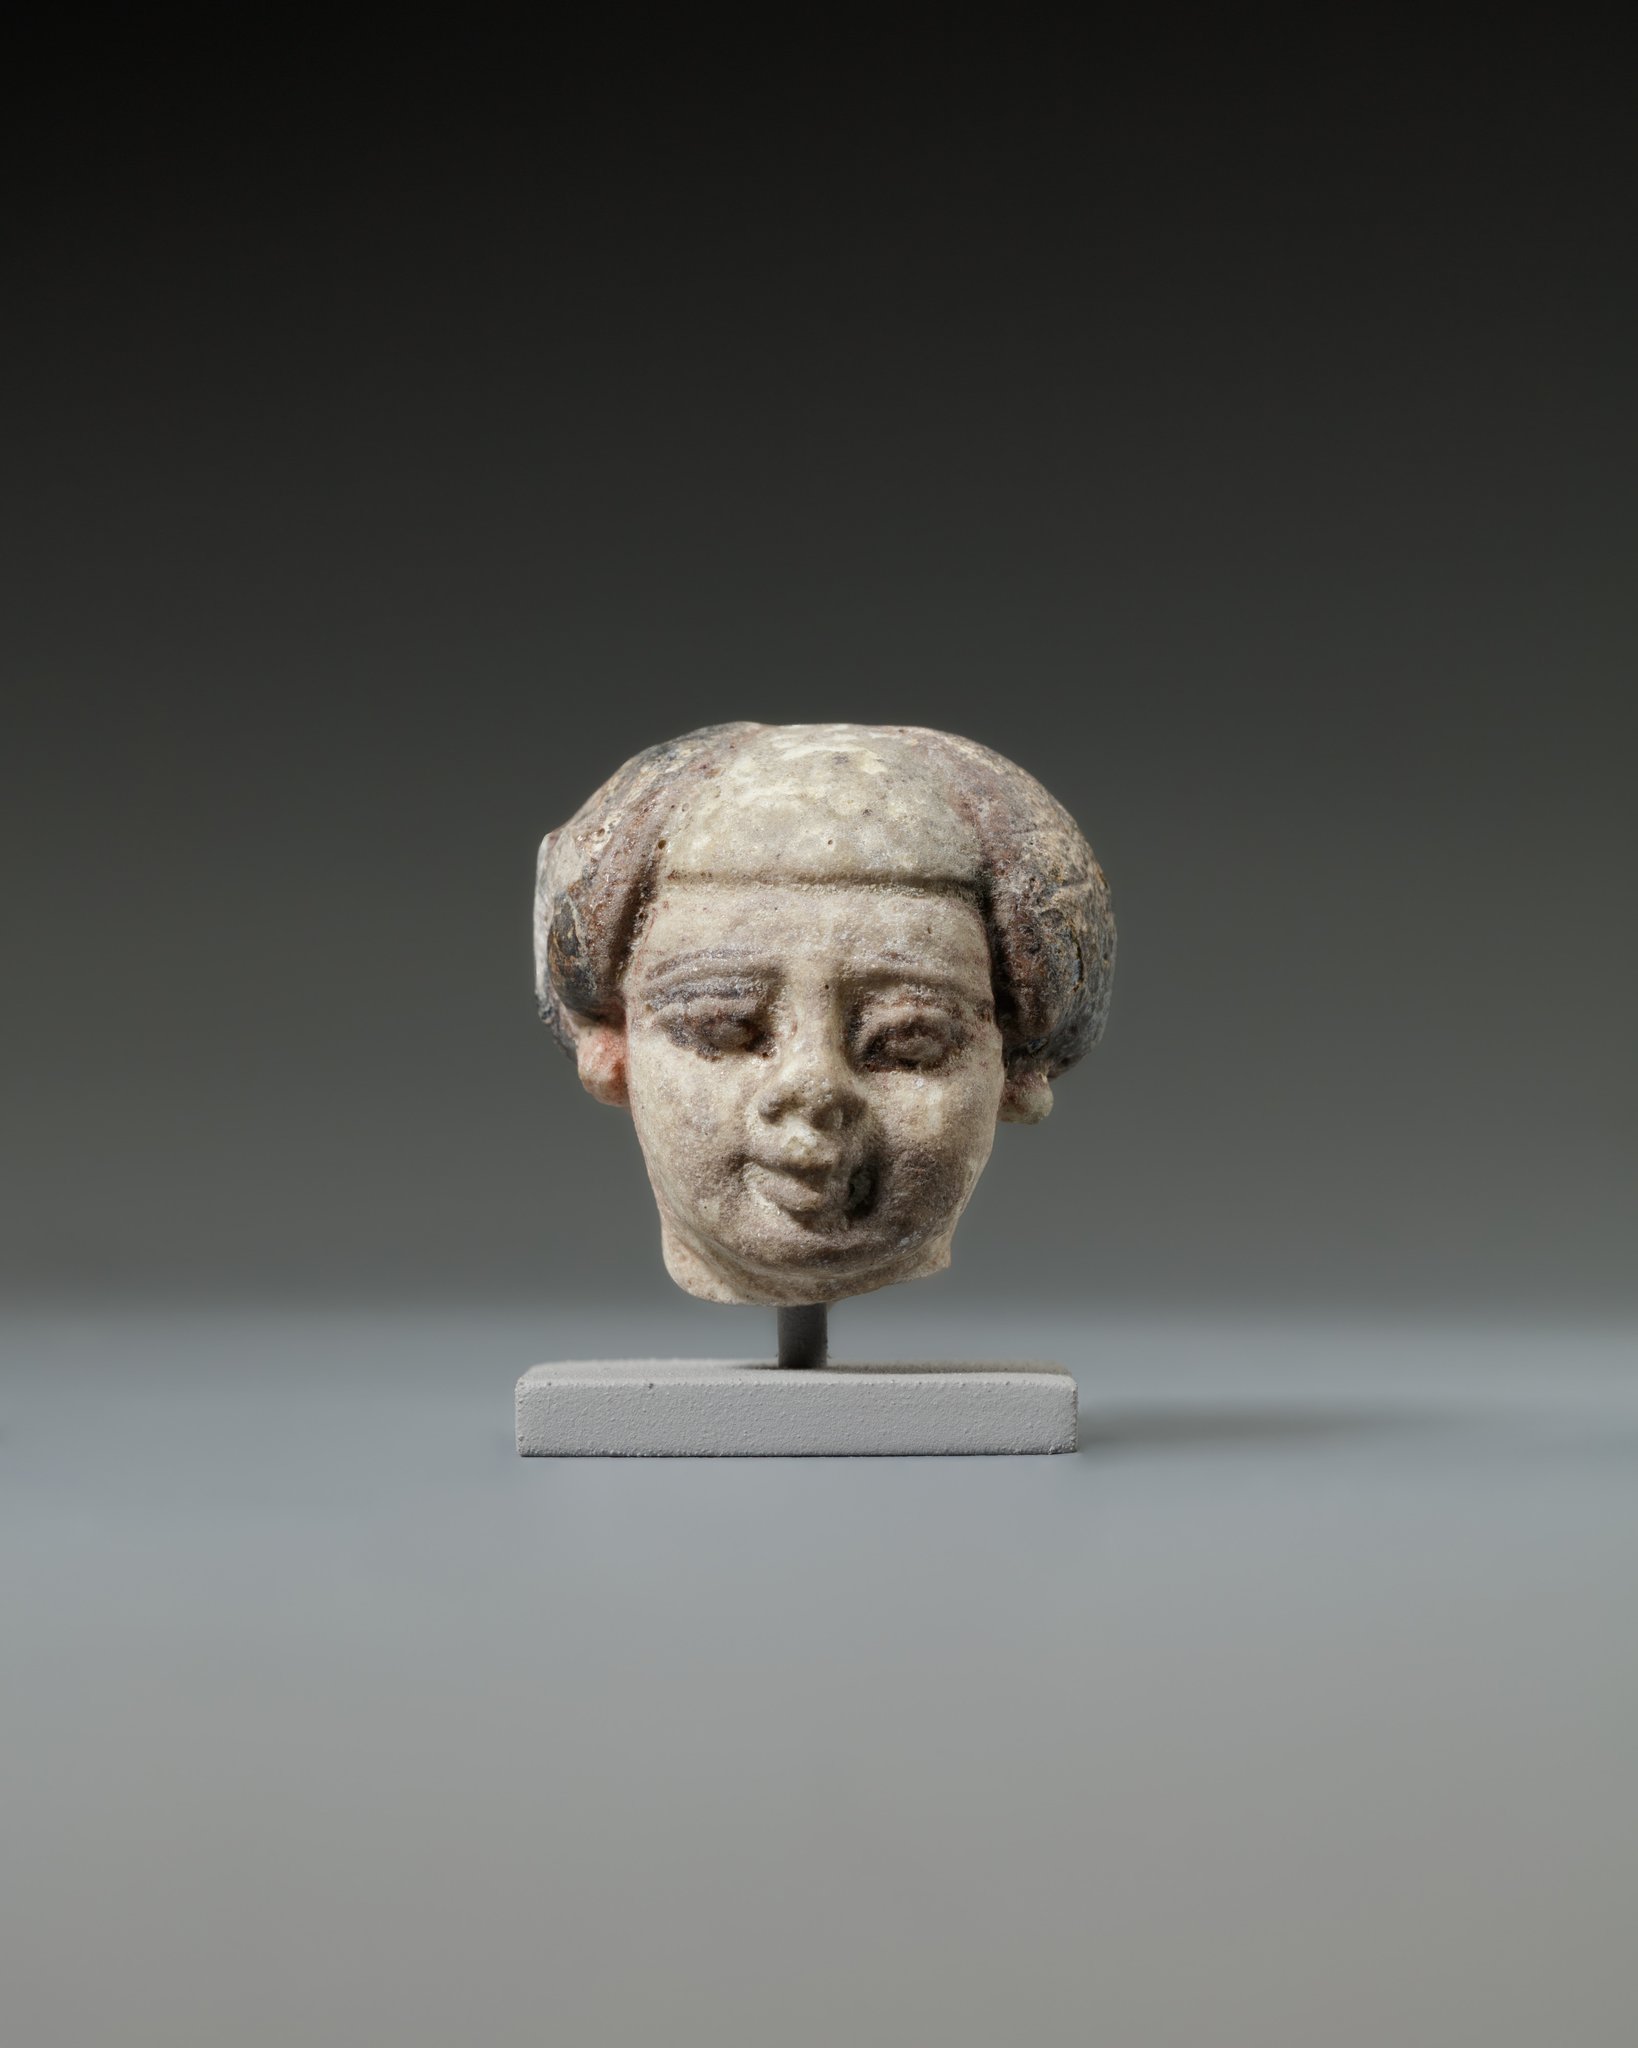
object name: statuette, dwarf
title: Head from a statuette, perhaps of a dwarf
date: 664-332 BCE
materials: faience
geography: egypt